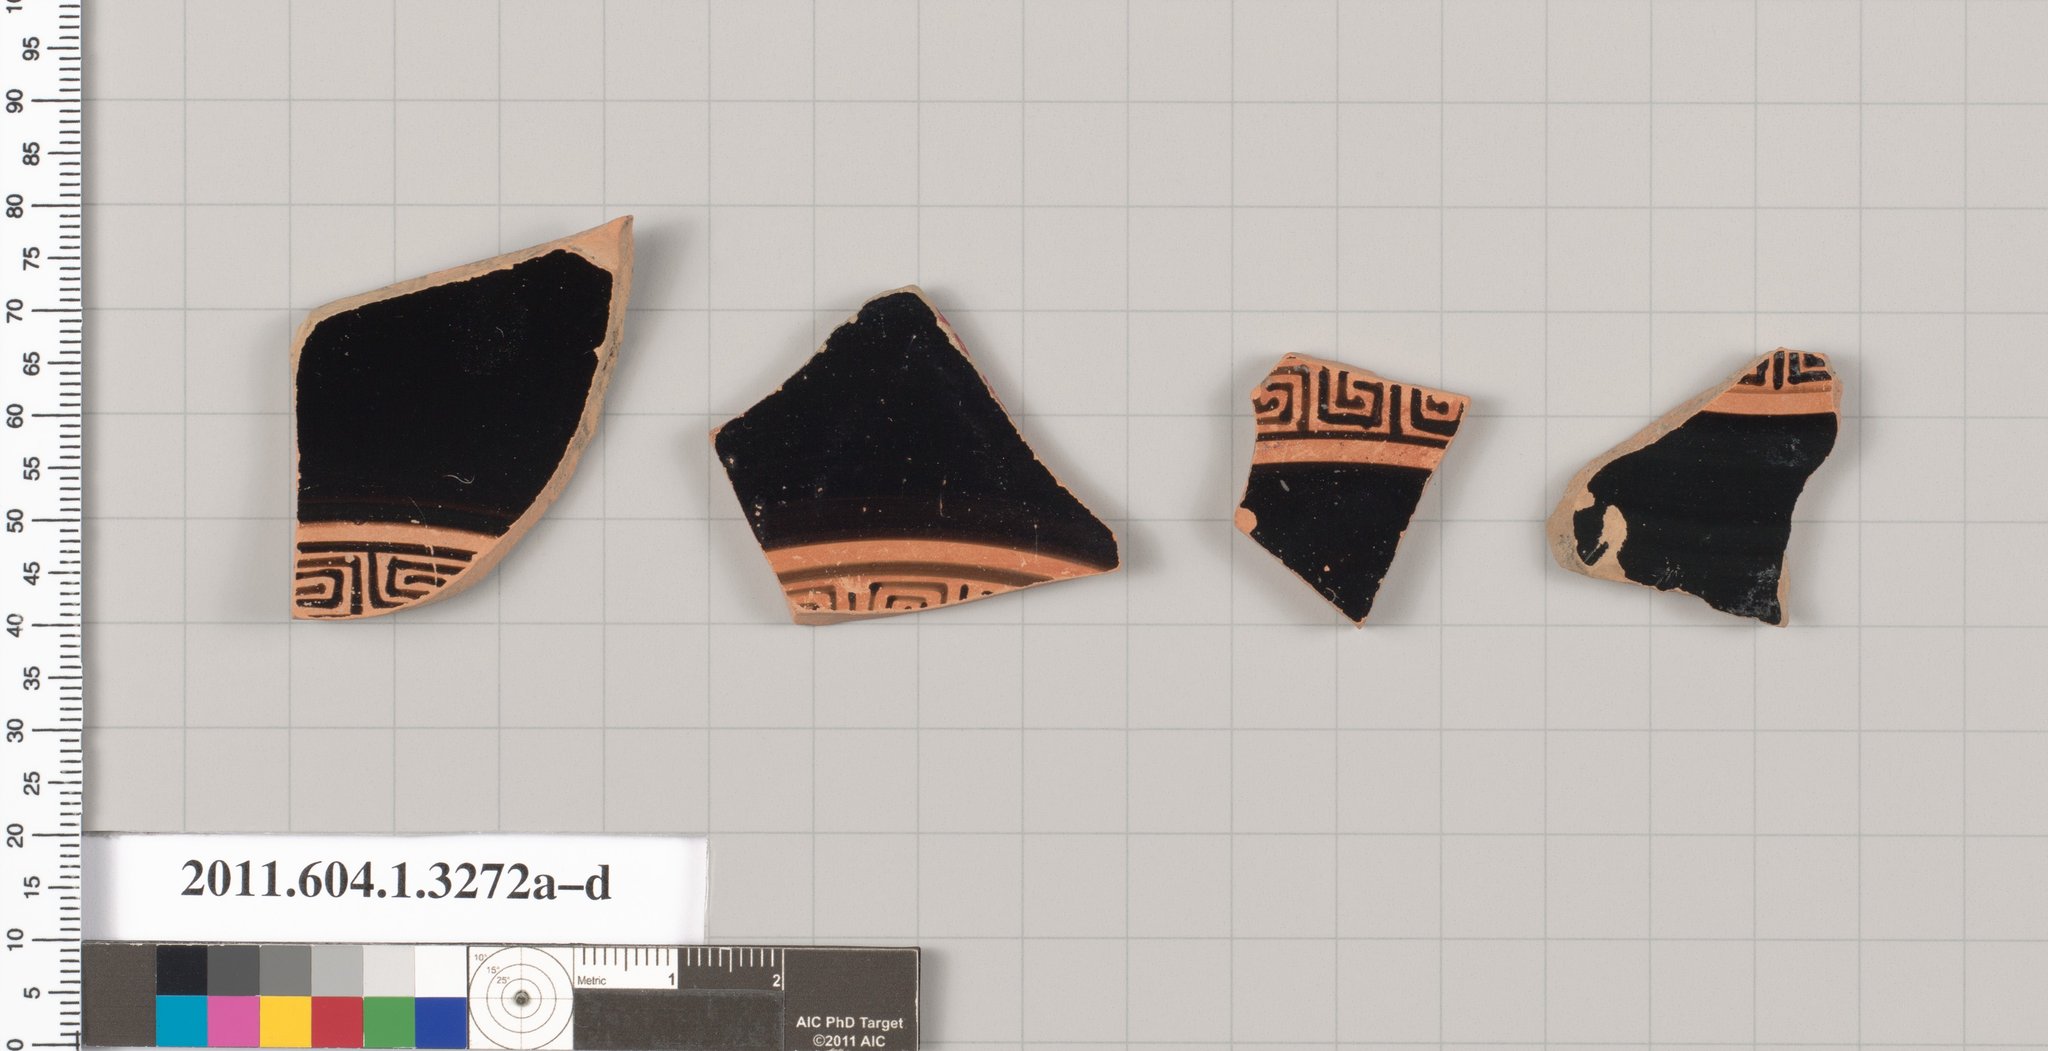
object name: kylix fragment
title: Terracotta fragments of kylikes (drinking cups)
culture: greek, attic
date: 500-490 BCE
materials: terracotta